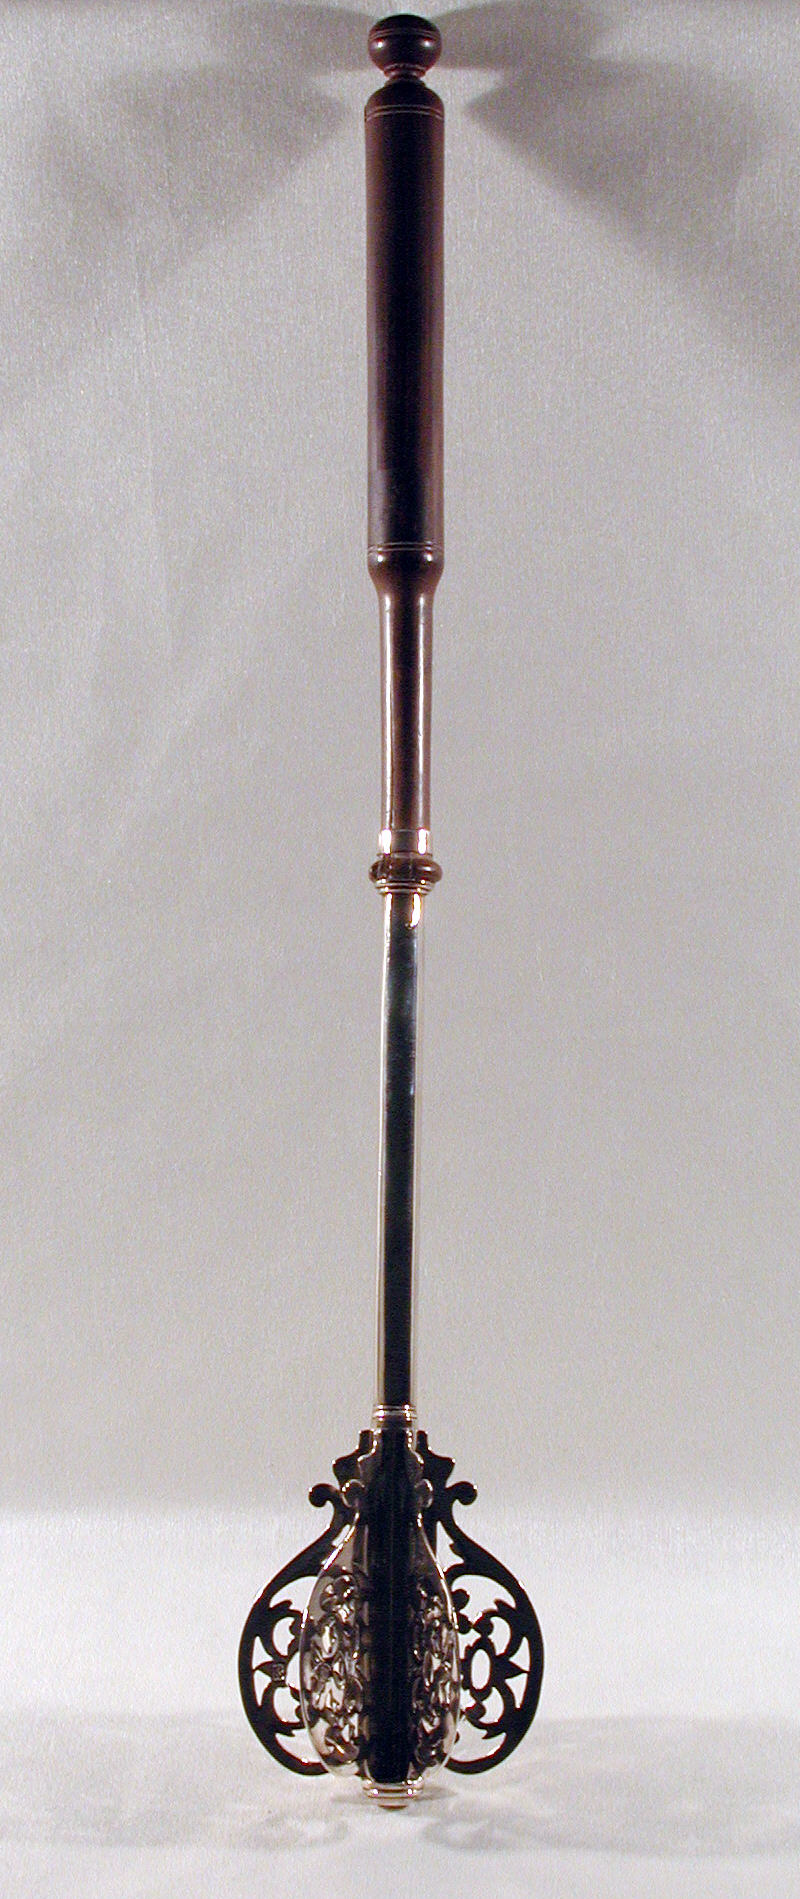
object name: moulinet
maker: john le sage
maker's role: maker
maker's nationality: british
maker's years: 1718-1743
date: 1739-1740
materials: silver, wood